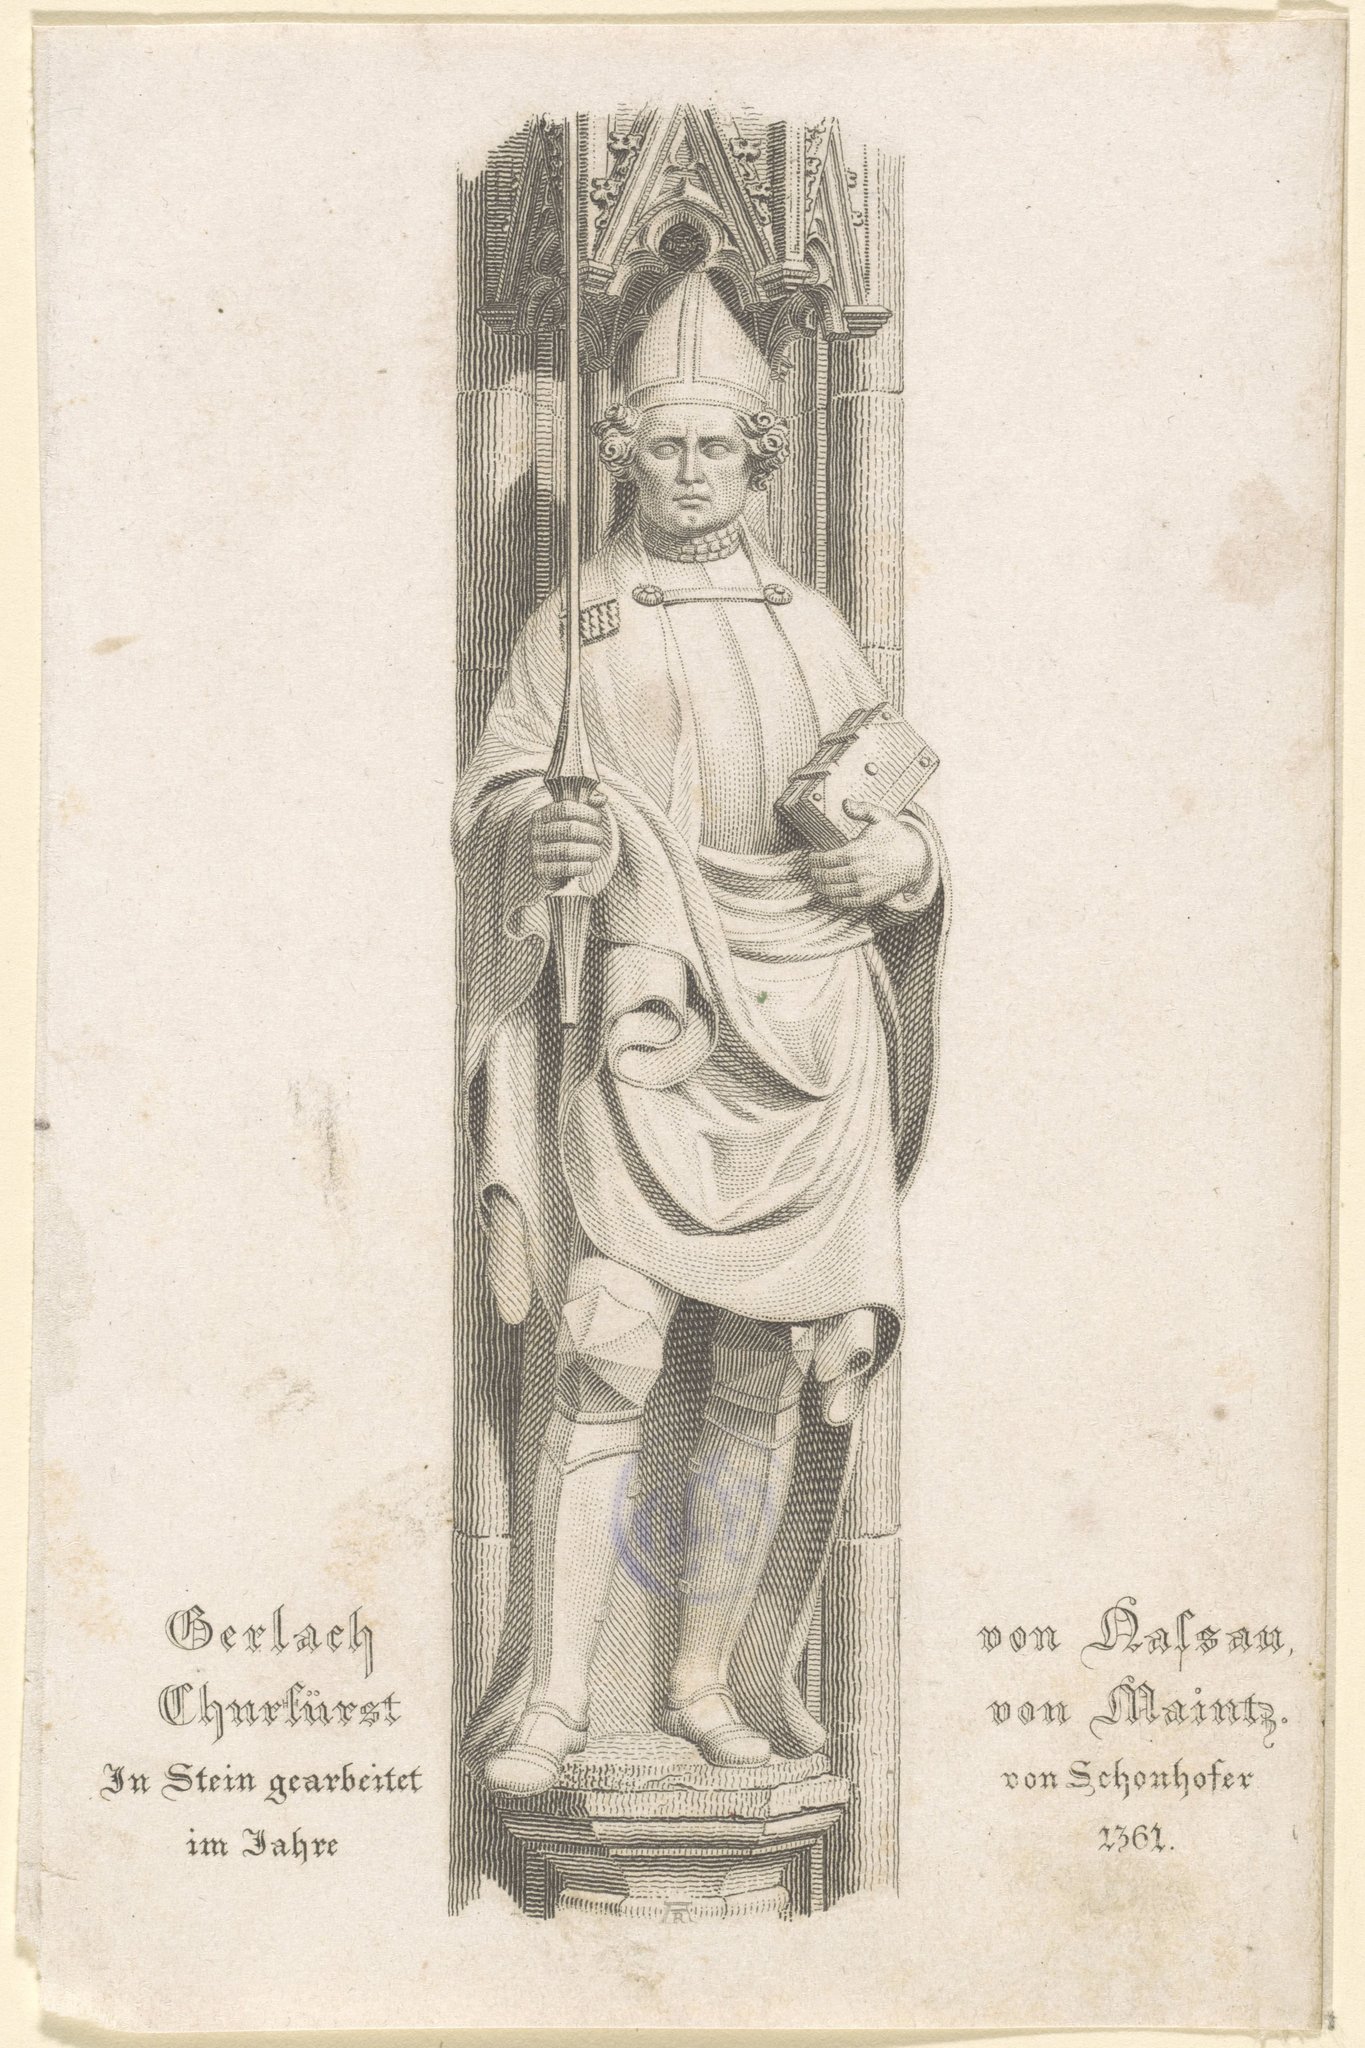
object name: print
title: Standbeeld van Gerlach van Nassau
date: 1600-1699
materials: paper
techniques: engraving, etching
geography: germany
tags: monument, statue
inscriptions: collector's mark: Lugt 2228, collector's mark: Lugt 4269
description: Standbeeld van Gerlach. Links en rechts zijn naam en titels.